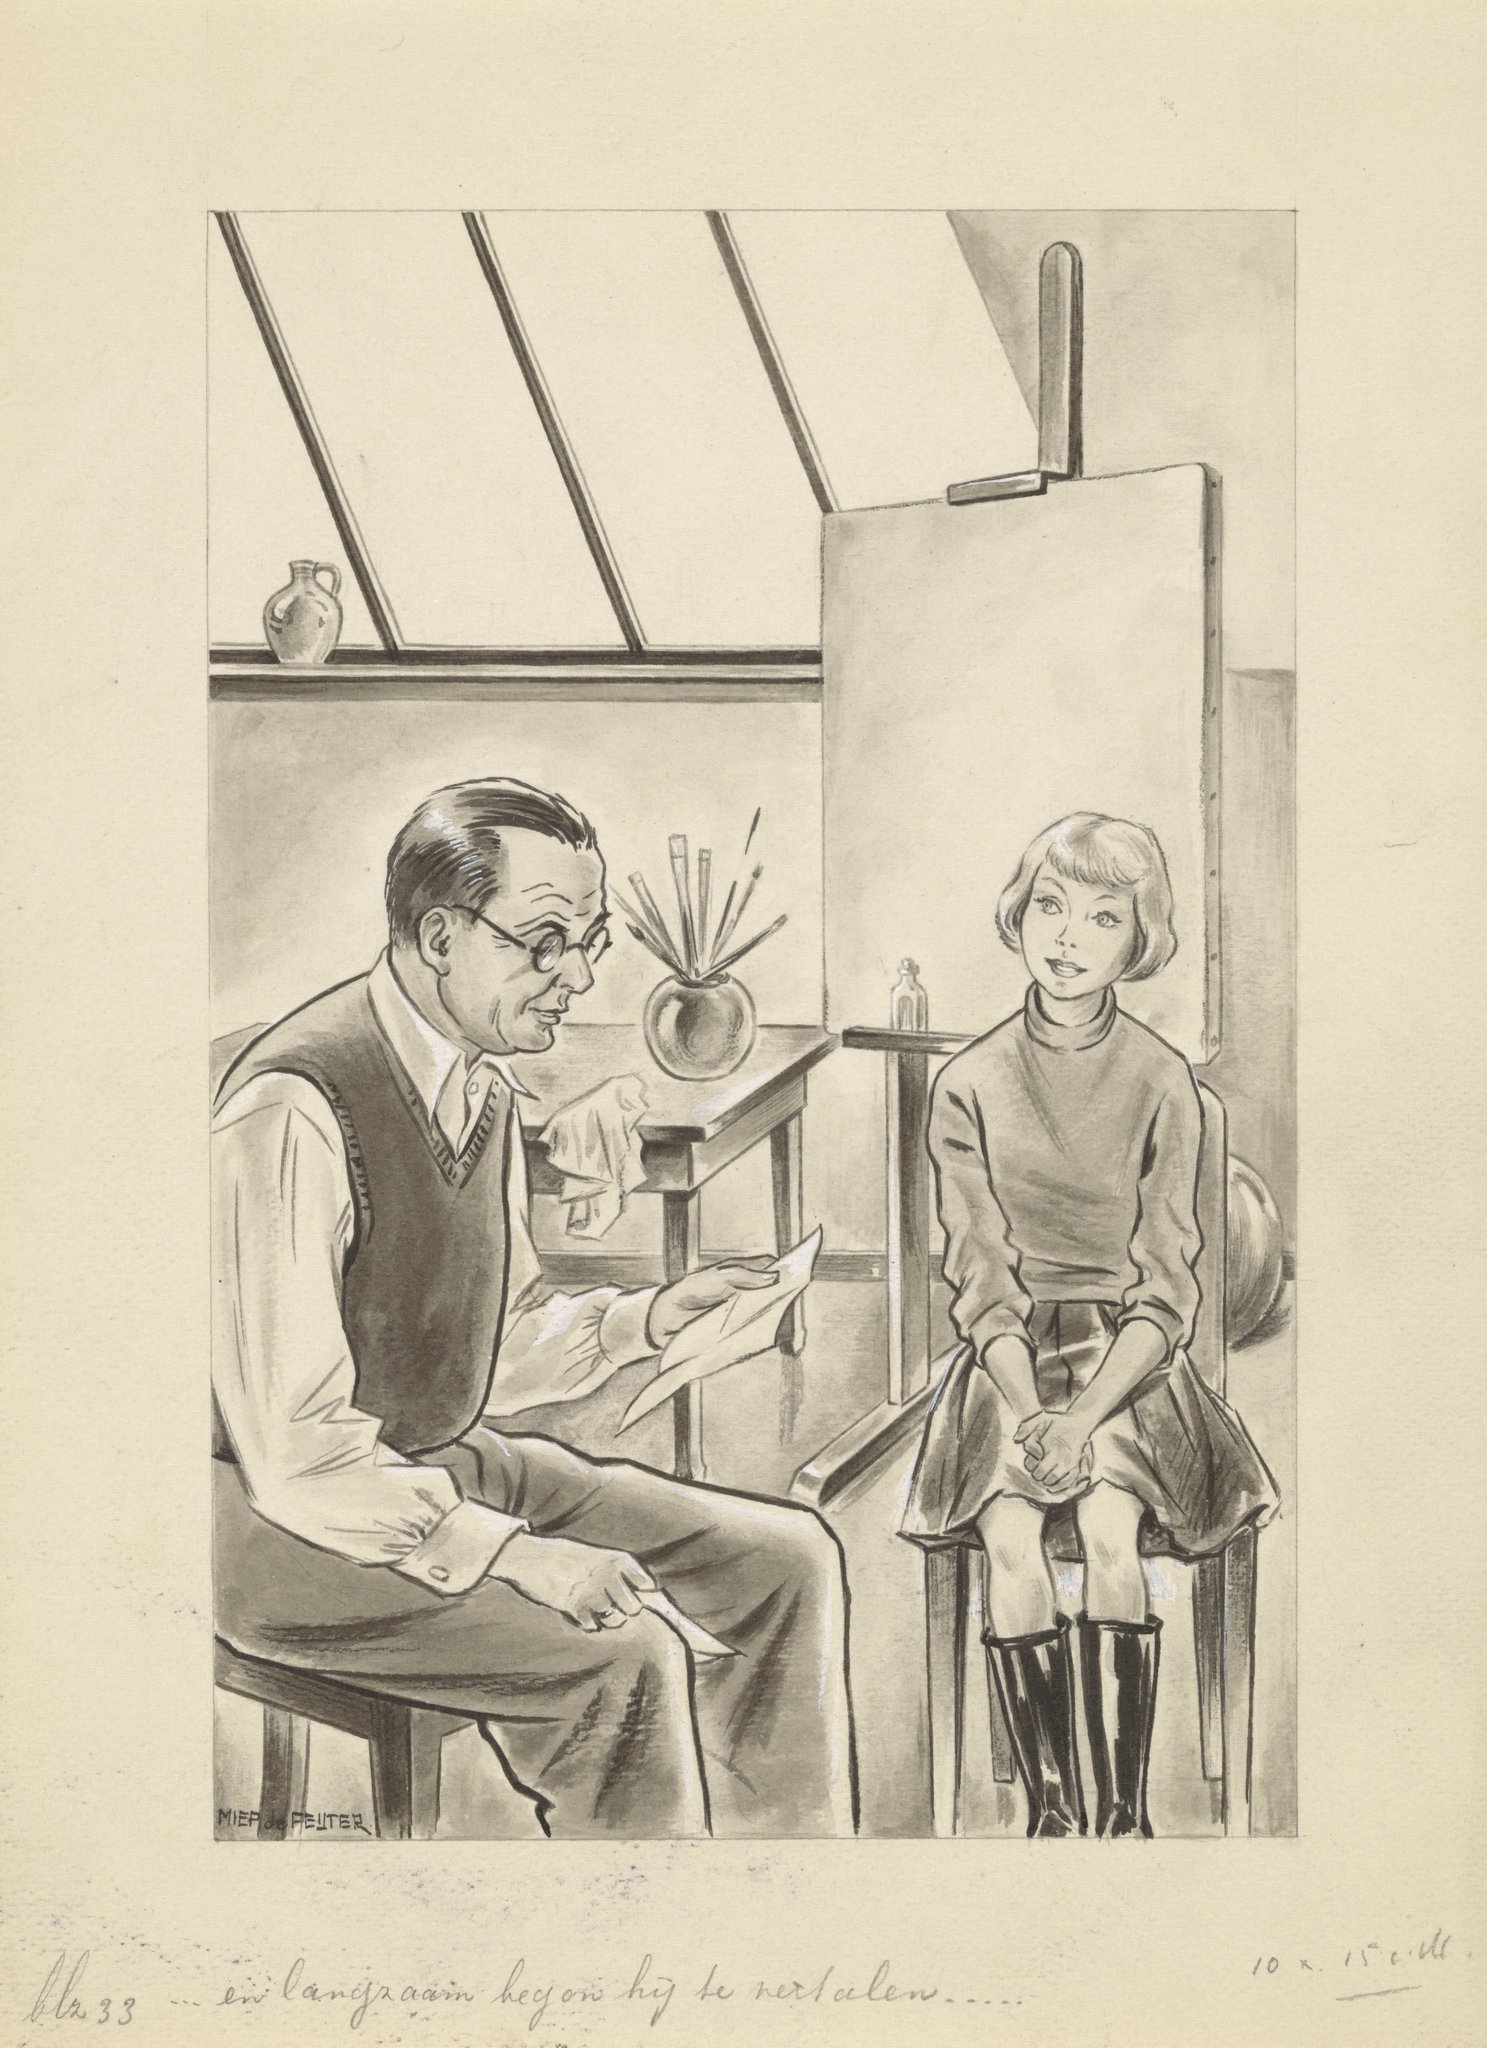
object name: drawing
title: Man en meisje in een schildersatelier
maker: miep de feijter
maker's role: draughtsman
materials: paint, ink, paper, pencil, watercolor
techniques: brush, pen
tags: sitting figure, reading, workshop, studio ~ painter, easel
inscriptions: signature: ‘MIEP de FEIJTER.’, :, collector's mark: Lugt 2228a, annotation: ‘blz 33 ... en langzaam begon hij te vertalen’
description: In een schildersatelier zit een meisje op een stoel naast een schildersezel waarop een doek staat. Ze kijkt naar een man die van een vel papier leest.